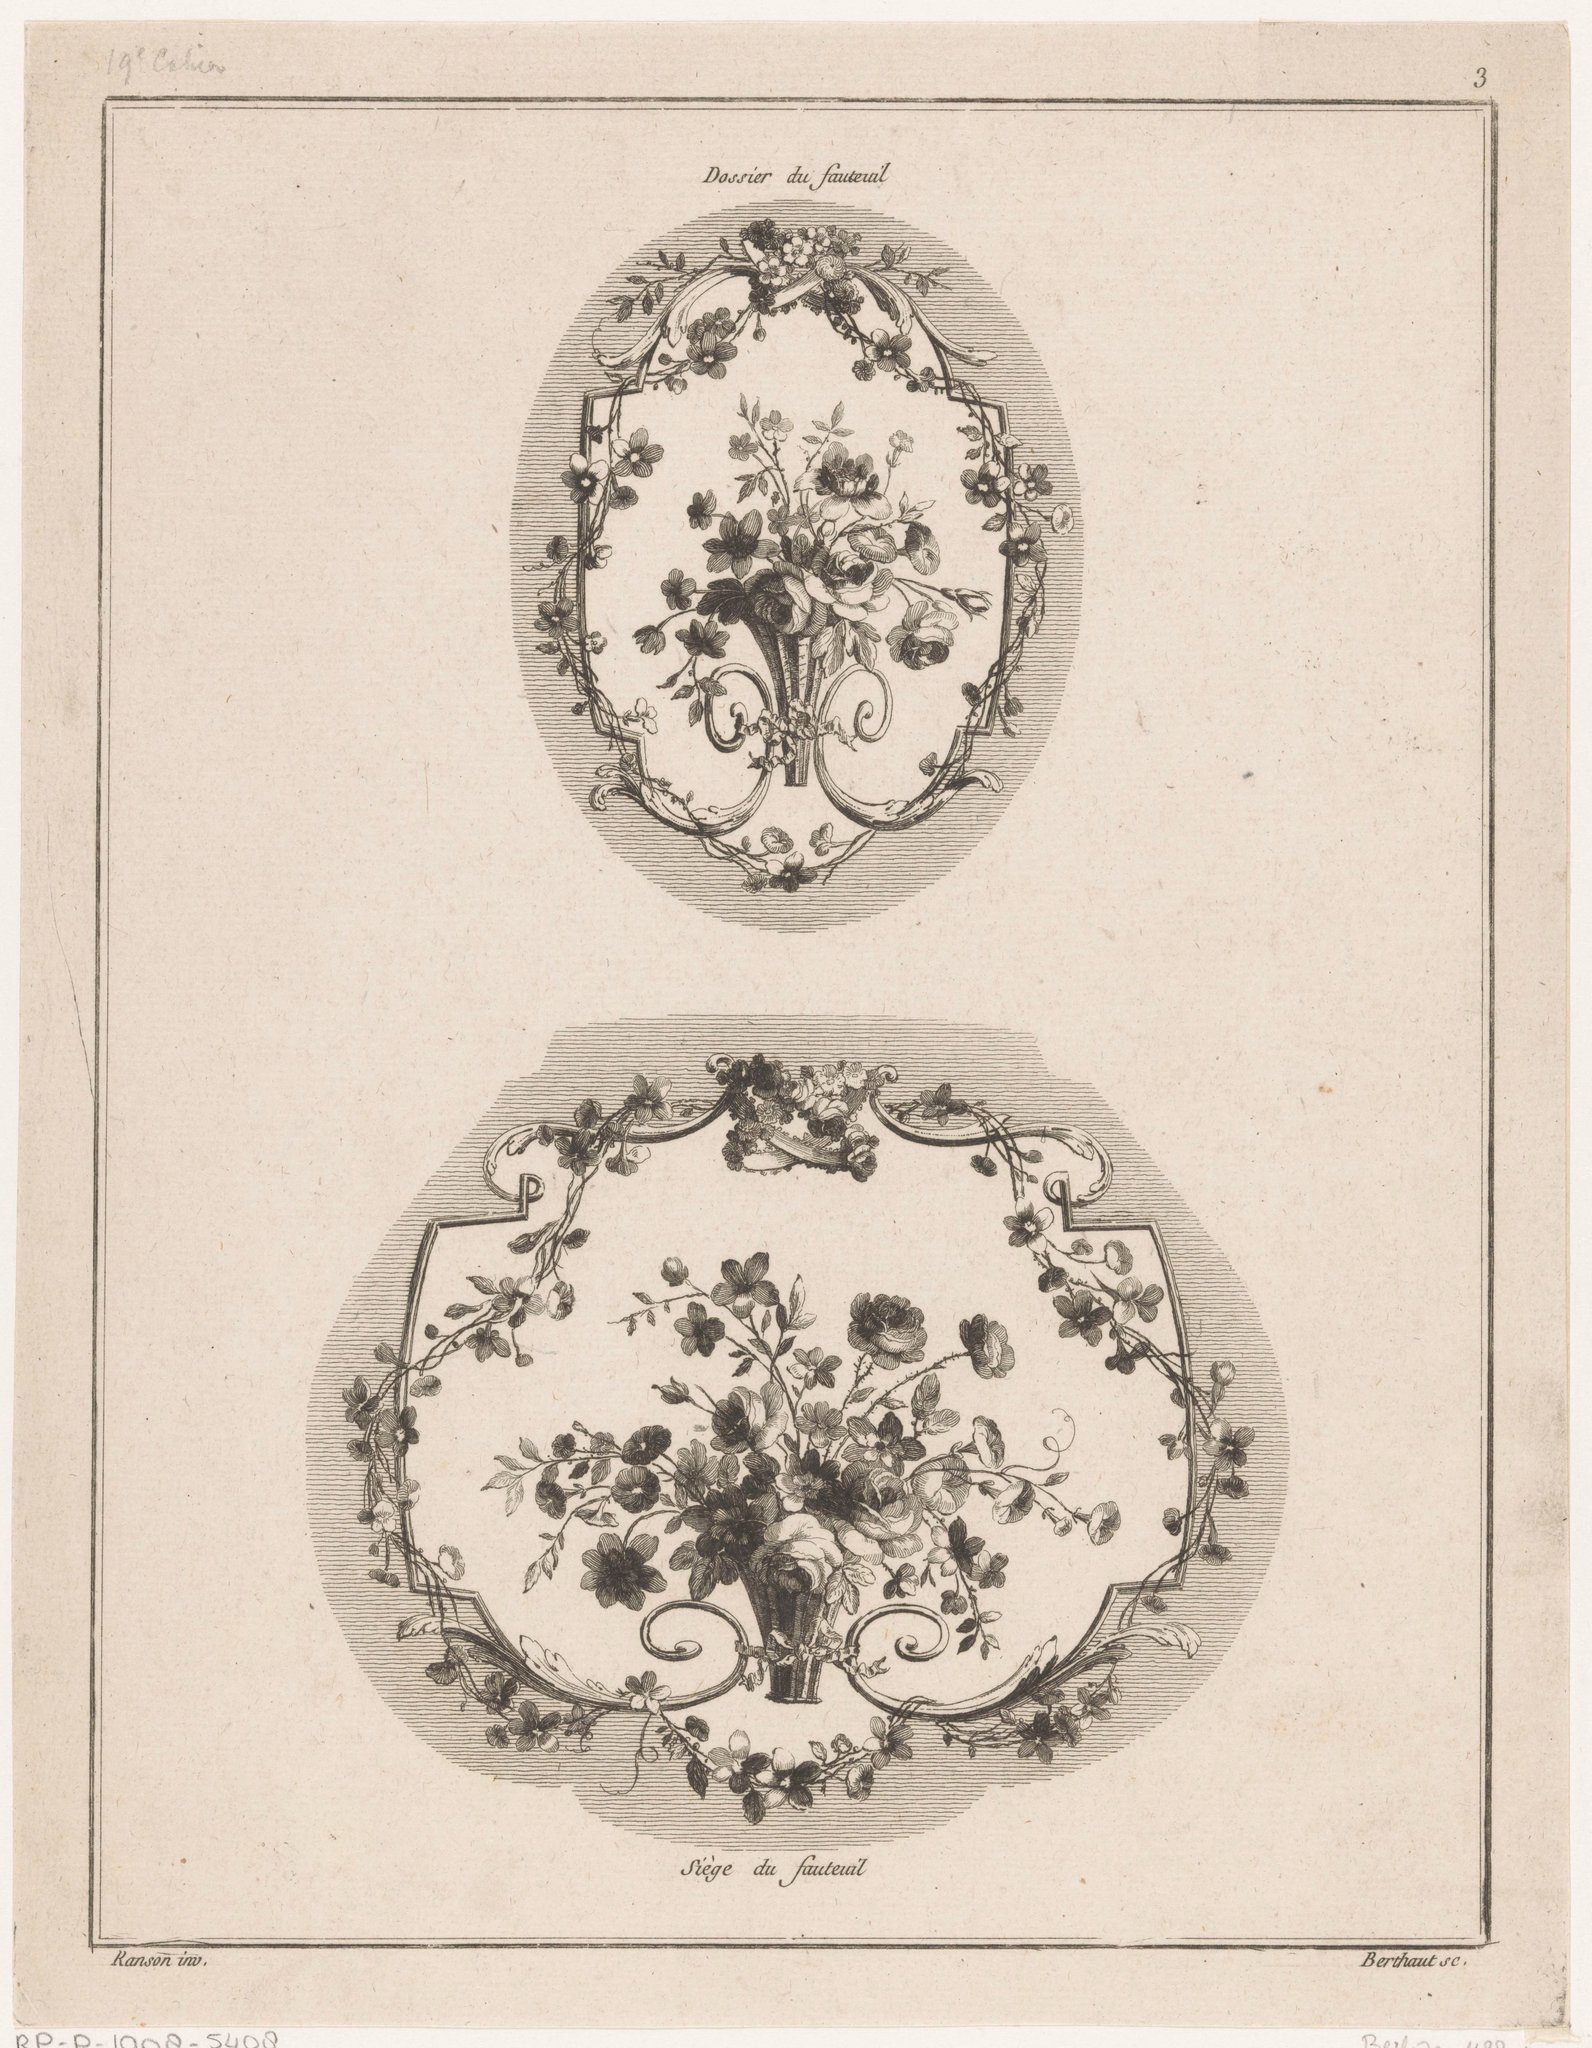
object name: ornament print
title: Stoelbekleding met bloemen en vazen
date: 1778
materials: paper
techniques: etching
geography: paris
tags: flowers in a vase, chair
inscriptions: collector's mark: Lugt 2228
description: Rug- en zitbekleding met een omlijsting van bloemen rondom een vaas met bloemen.